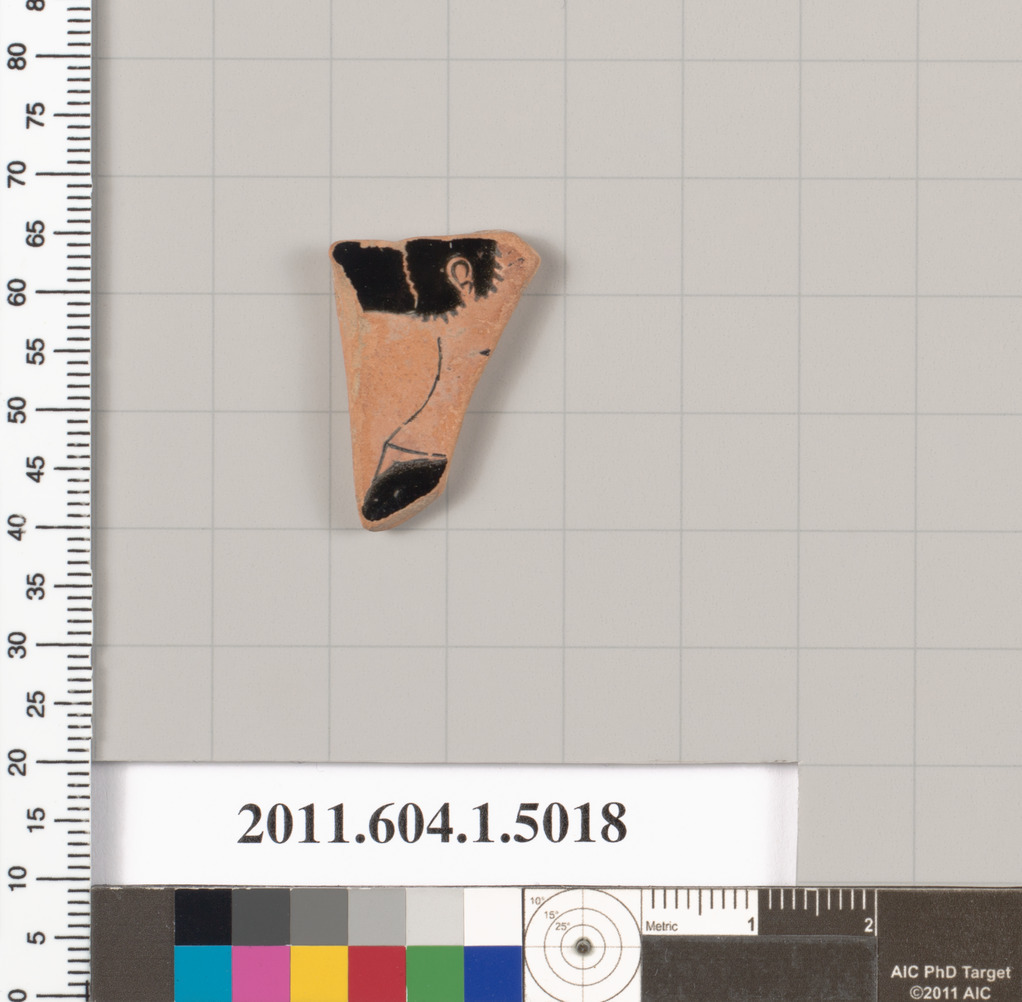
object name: kylix fragment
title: Terracotta fragment of a kylix (drinking cup)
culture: greek, attic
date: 500-480 BCE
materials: terracotta